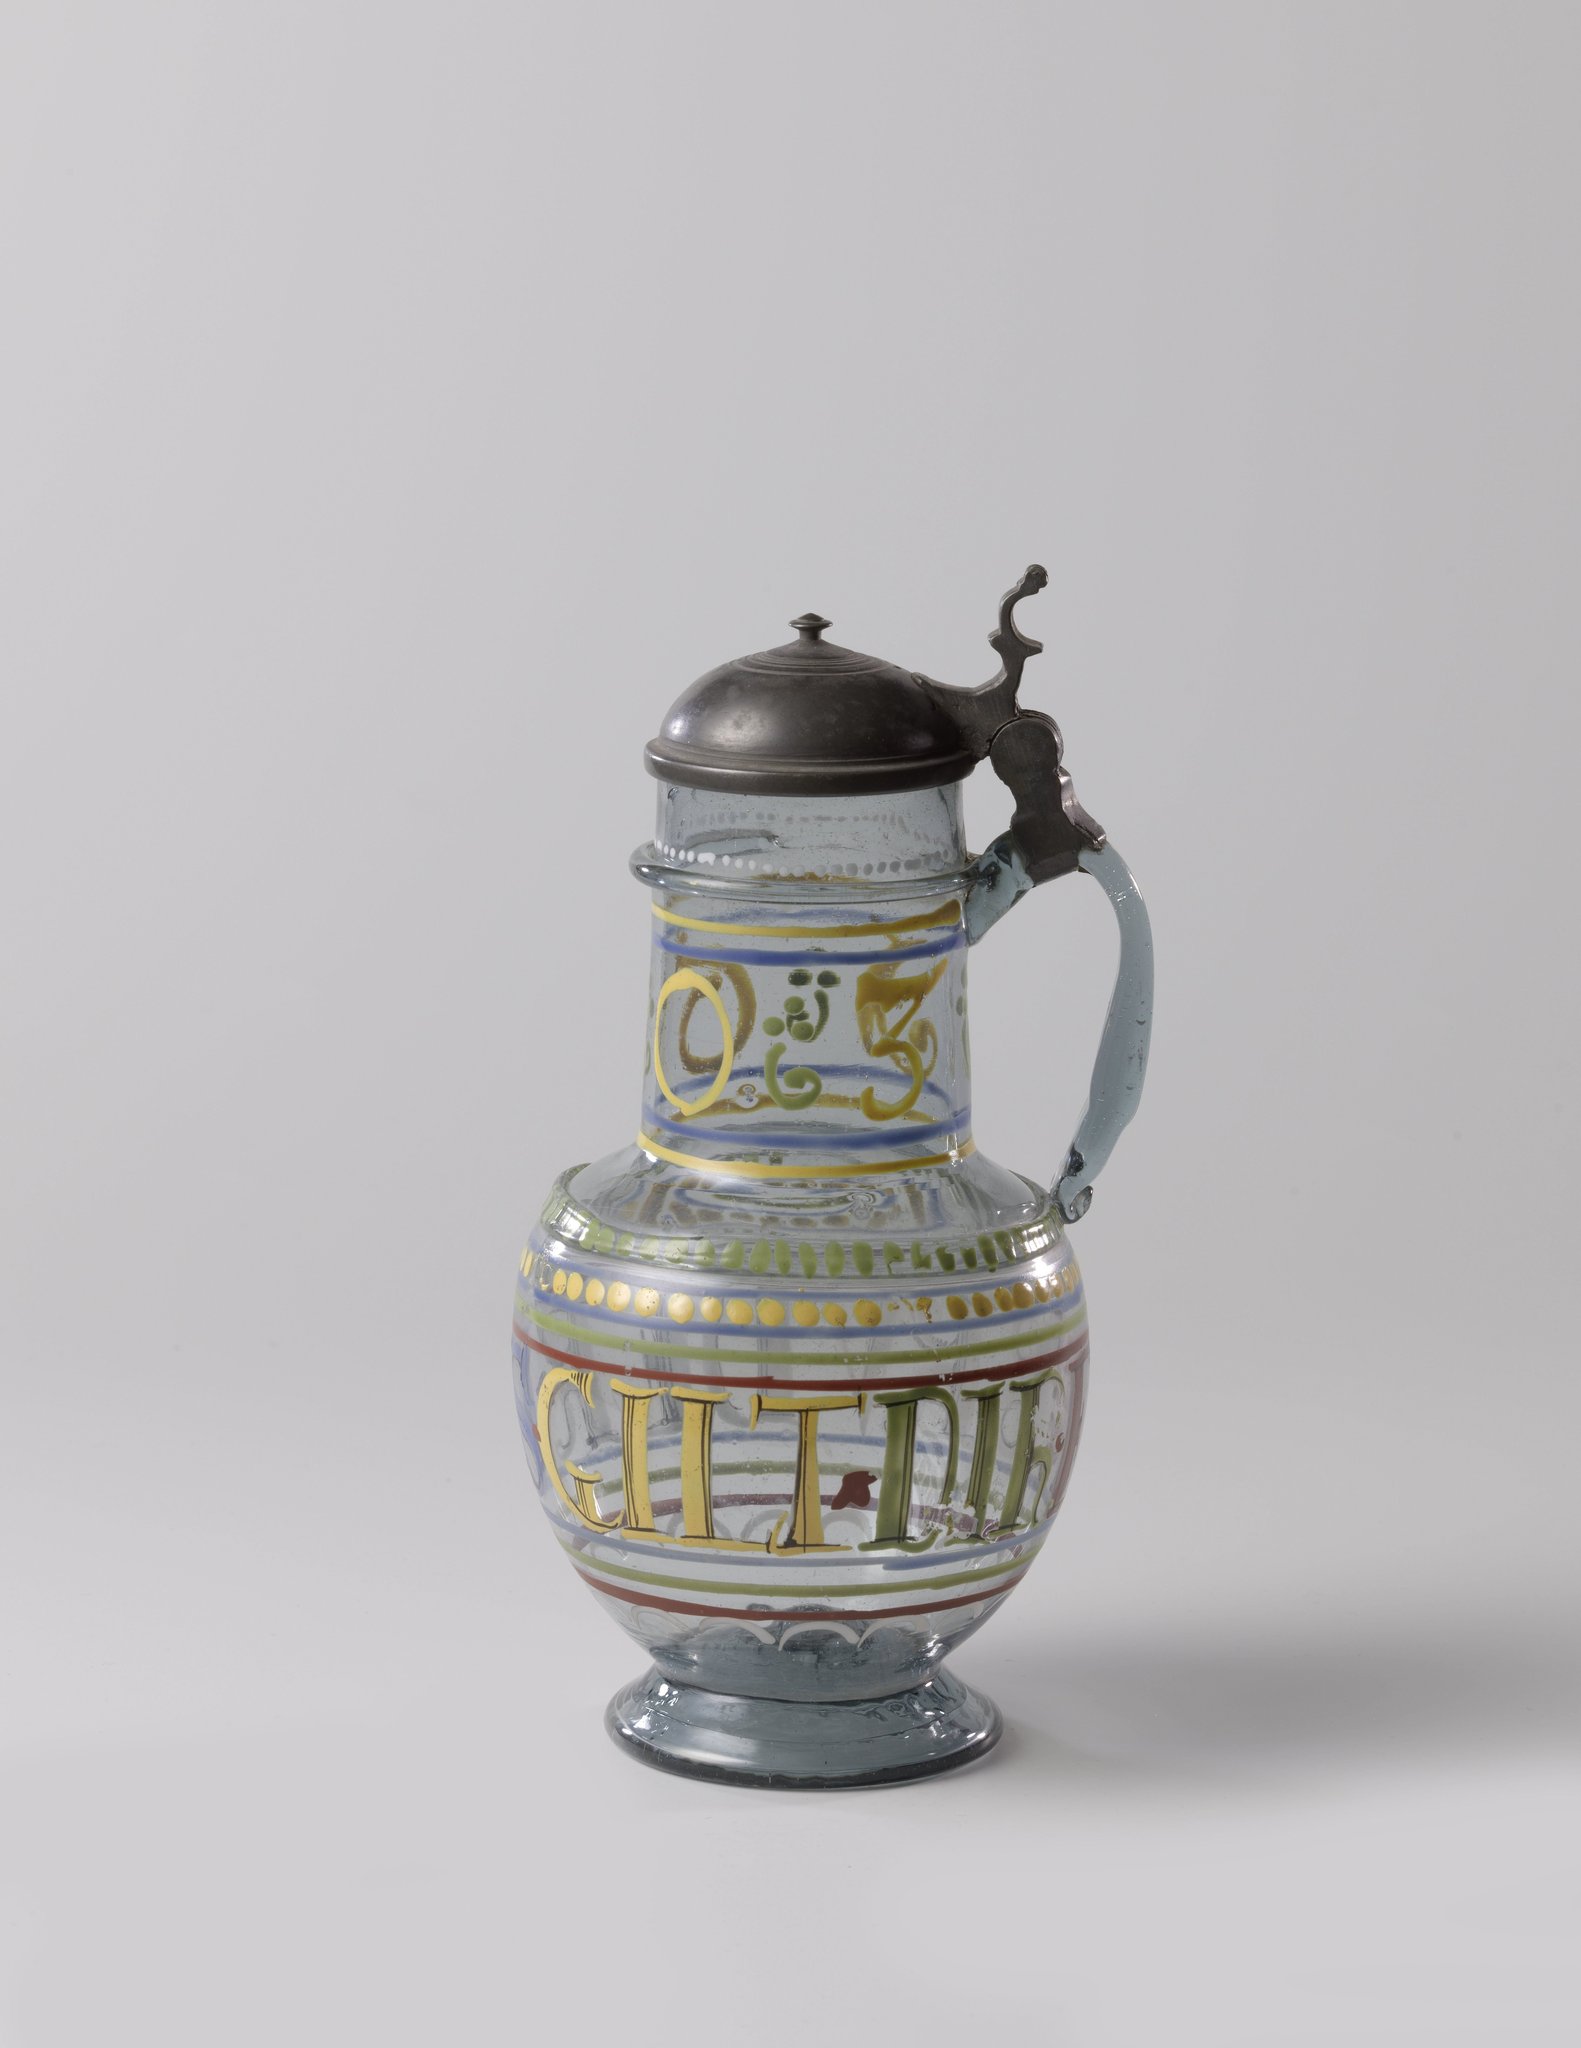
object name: lid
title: Jug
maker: Anonymous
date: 1603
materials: glass, tin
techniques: glassblowing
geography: bohemia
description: Licht ingestoken bodem. Gladde, licht conische voet met omgeslagen rand, bolvormig lichaam onder een vrijwel cylindervormige hals. Aangezet, glad, C-vormig oor. Een met groene stippen beschilderde gladde glasdraad rond het lichaam ter hoogte van de onderaanzet van het oor, een gladde glasdraad op de hals ter hoogte van de bovenaanzet. Het lichaam in wit, geel, blauw, groen en rood beschilderd met het opschrift BRUDER.ES.GILT.DIR.EINS tussen gladde en gestipte biezen. Op de hals in geel het jaartal 1603, de cijfers gescheiden door groene bloempjes en onder en boven afgezet met gladde en gestipte biezen. Gewelfd deksel van tin, scharnierend gemonteerd op het oor en voorzien van een duimstuk.